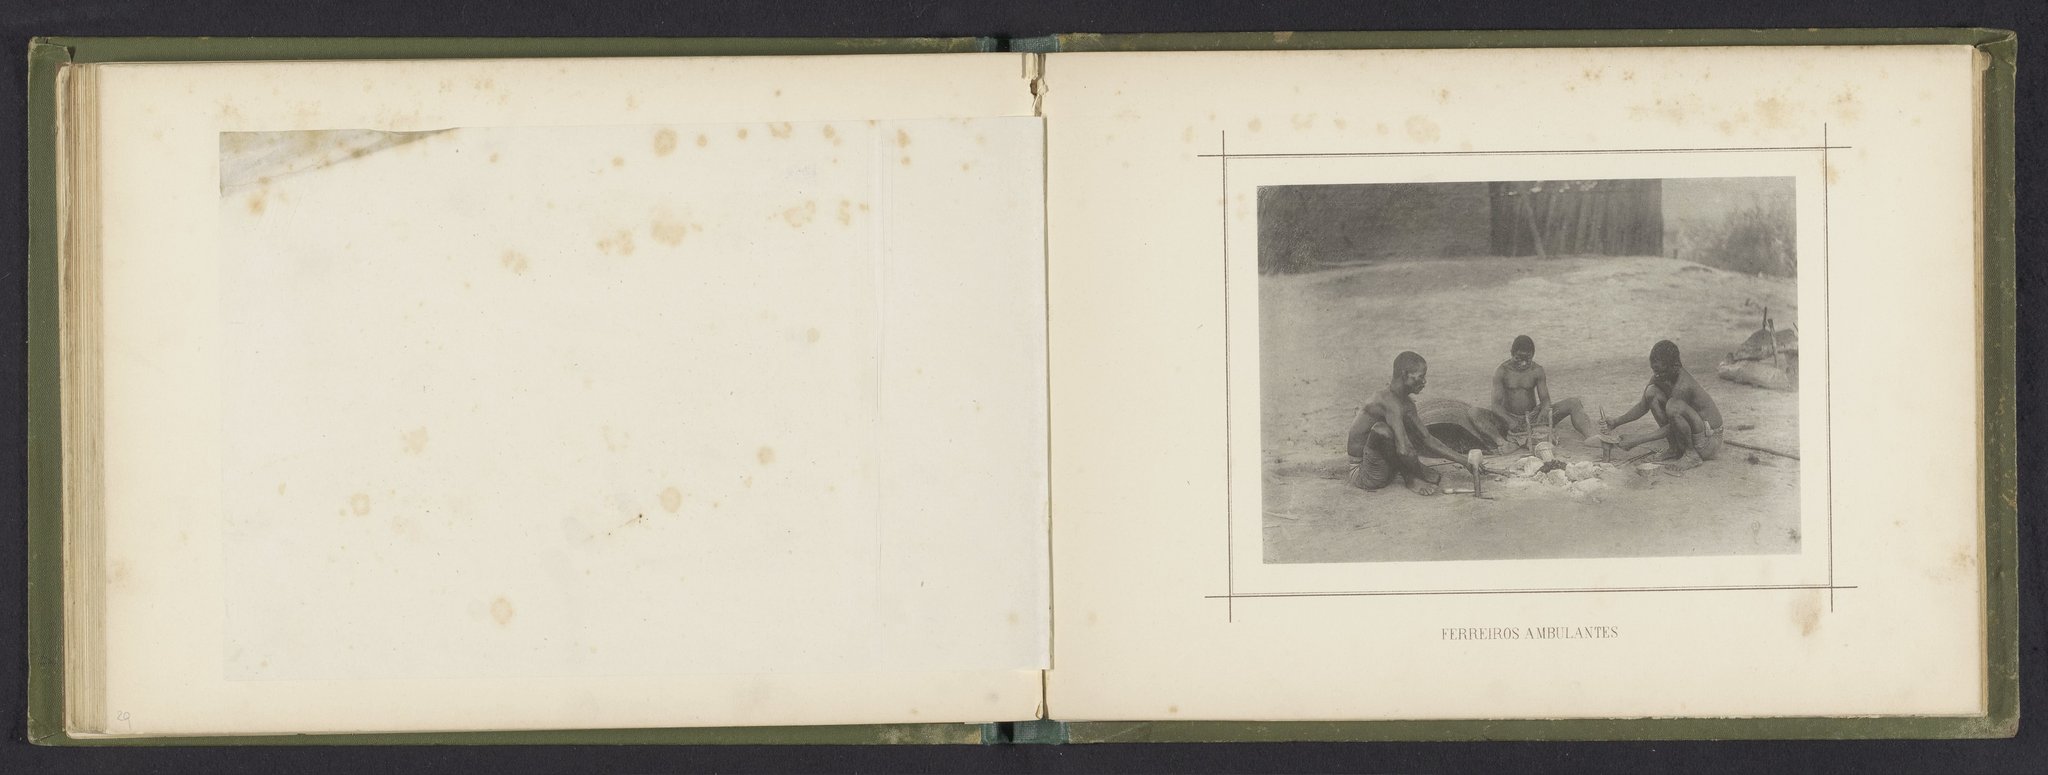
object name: photomechanical print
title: Straatsmeden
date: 1876-1886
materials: paper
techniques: photograph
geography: angola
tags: open fire (in general), smith, blacksmith, street